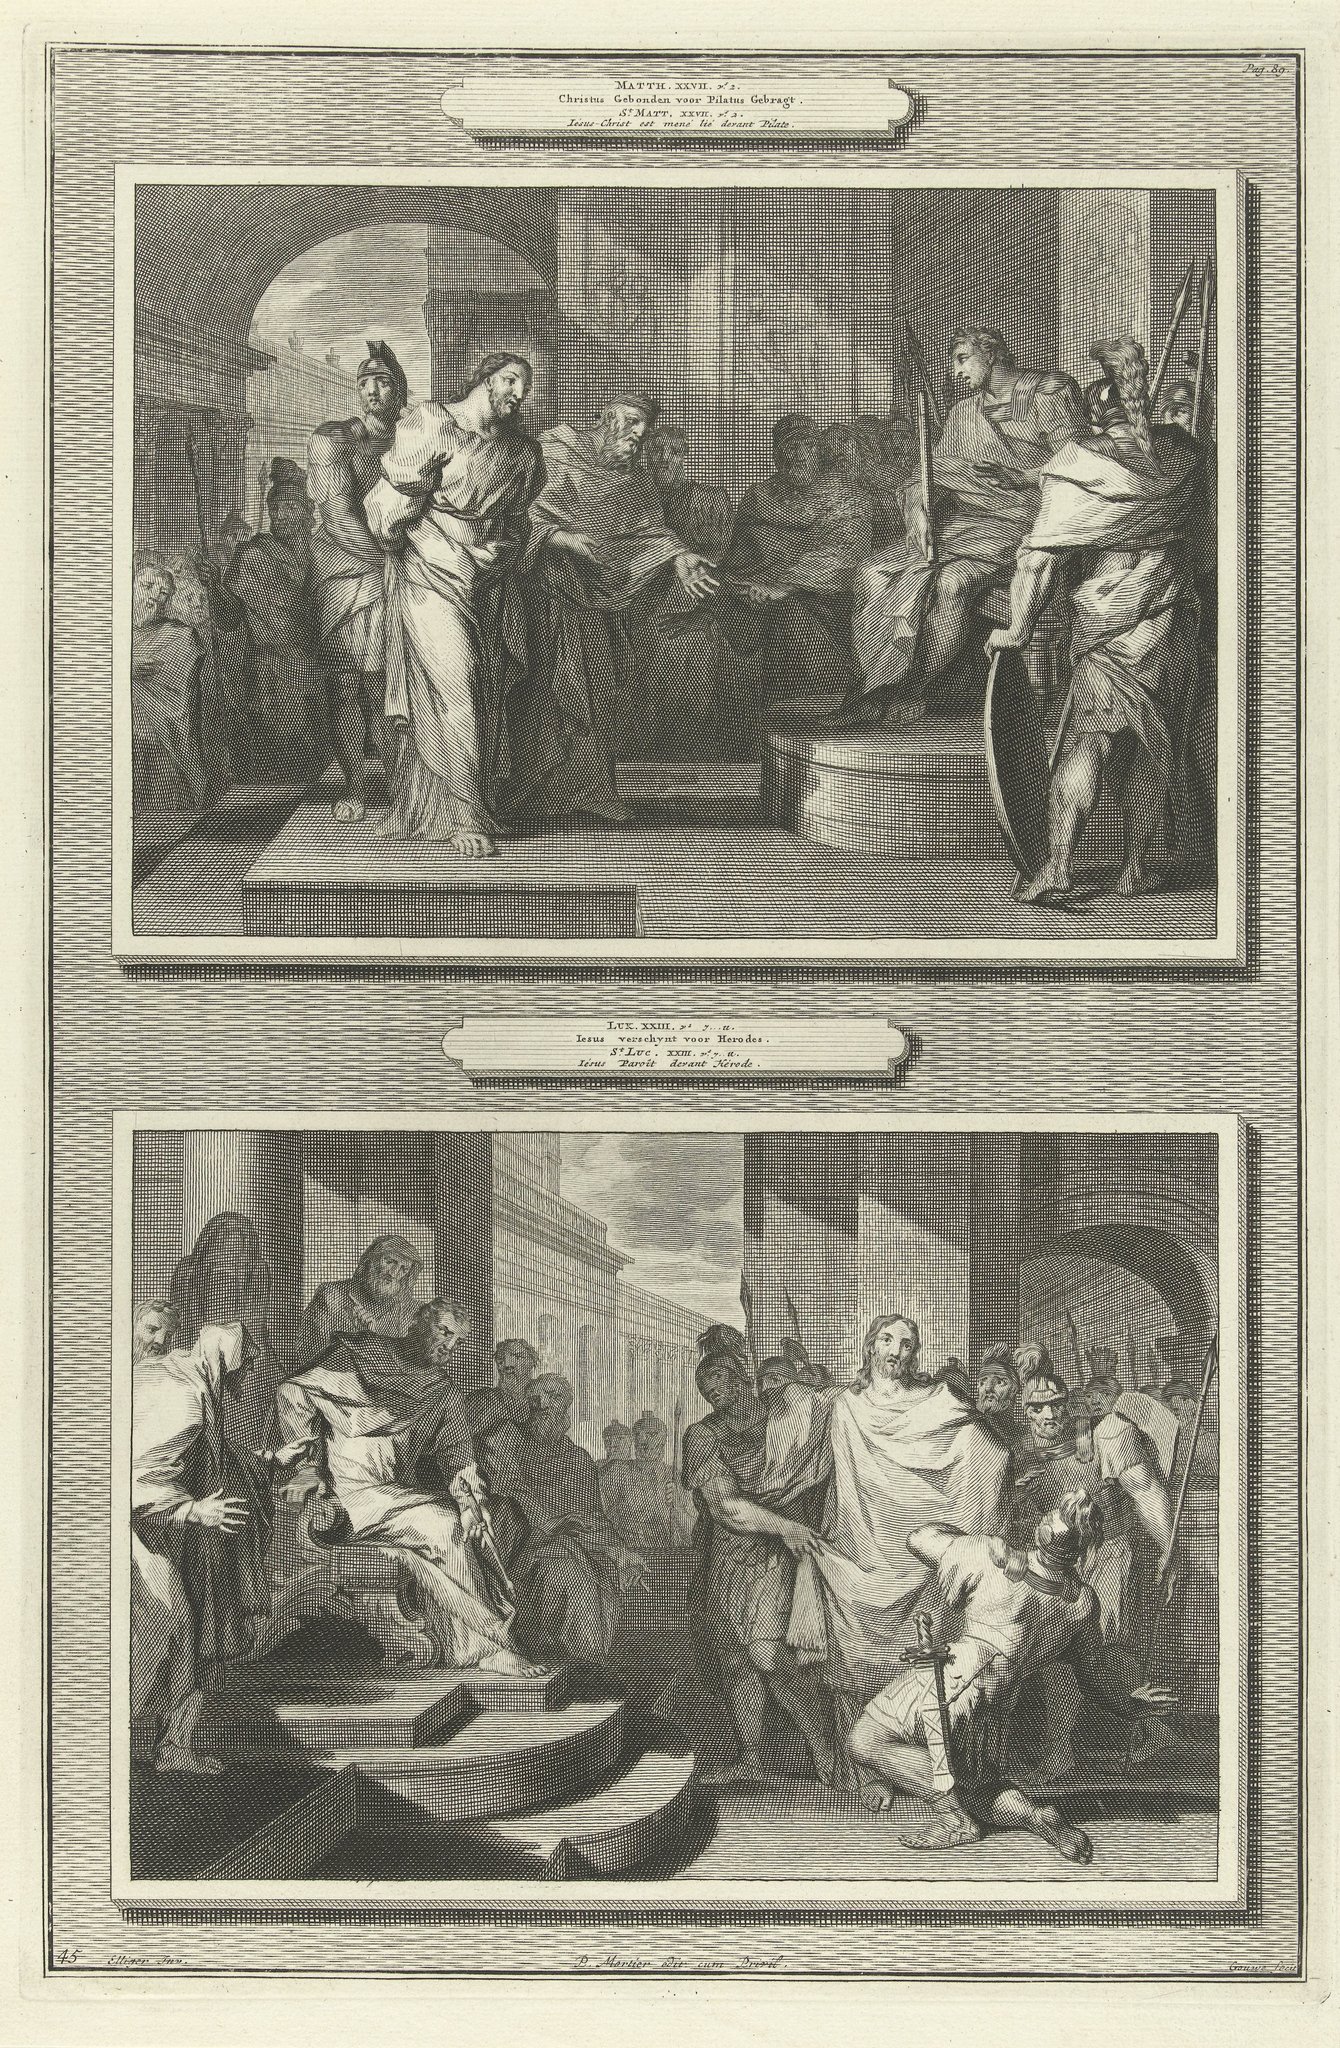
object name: book illustration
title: Christus voor Pilatus en voor Herodes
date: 1700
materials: paper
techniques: engraving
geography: amsterdam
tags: christ before pontius pilate (matthew 27:11-26; mark 15:2-15; luke 23:2-7, 23:13-25; john 18:28 - 19:16), christ before king herod; sometimes a gorgeous robe is brought (luke 23:8-11)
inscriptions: collector's mark: Lugt 2228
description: Twee voorstellingen. Boven: Christus voor Pilatus (Matt. 27).. Pilatus vraagt hem of hij de koning van de joden is. Onder: Christus voor Herodes. Herodes laat Christus een prachtig wit gewaad dragen (Lucas 23:8-12).